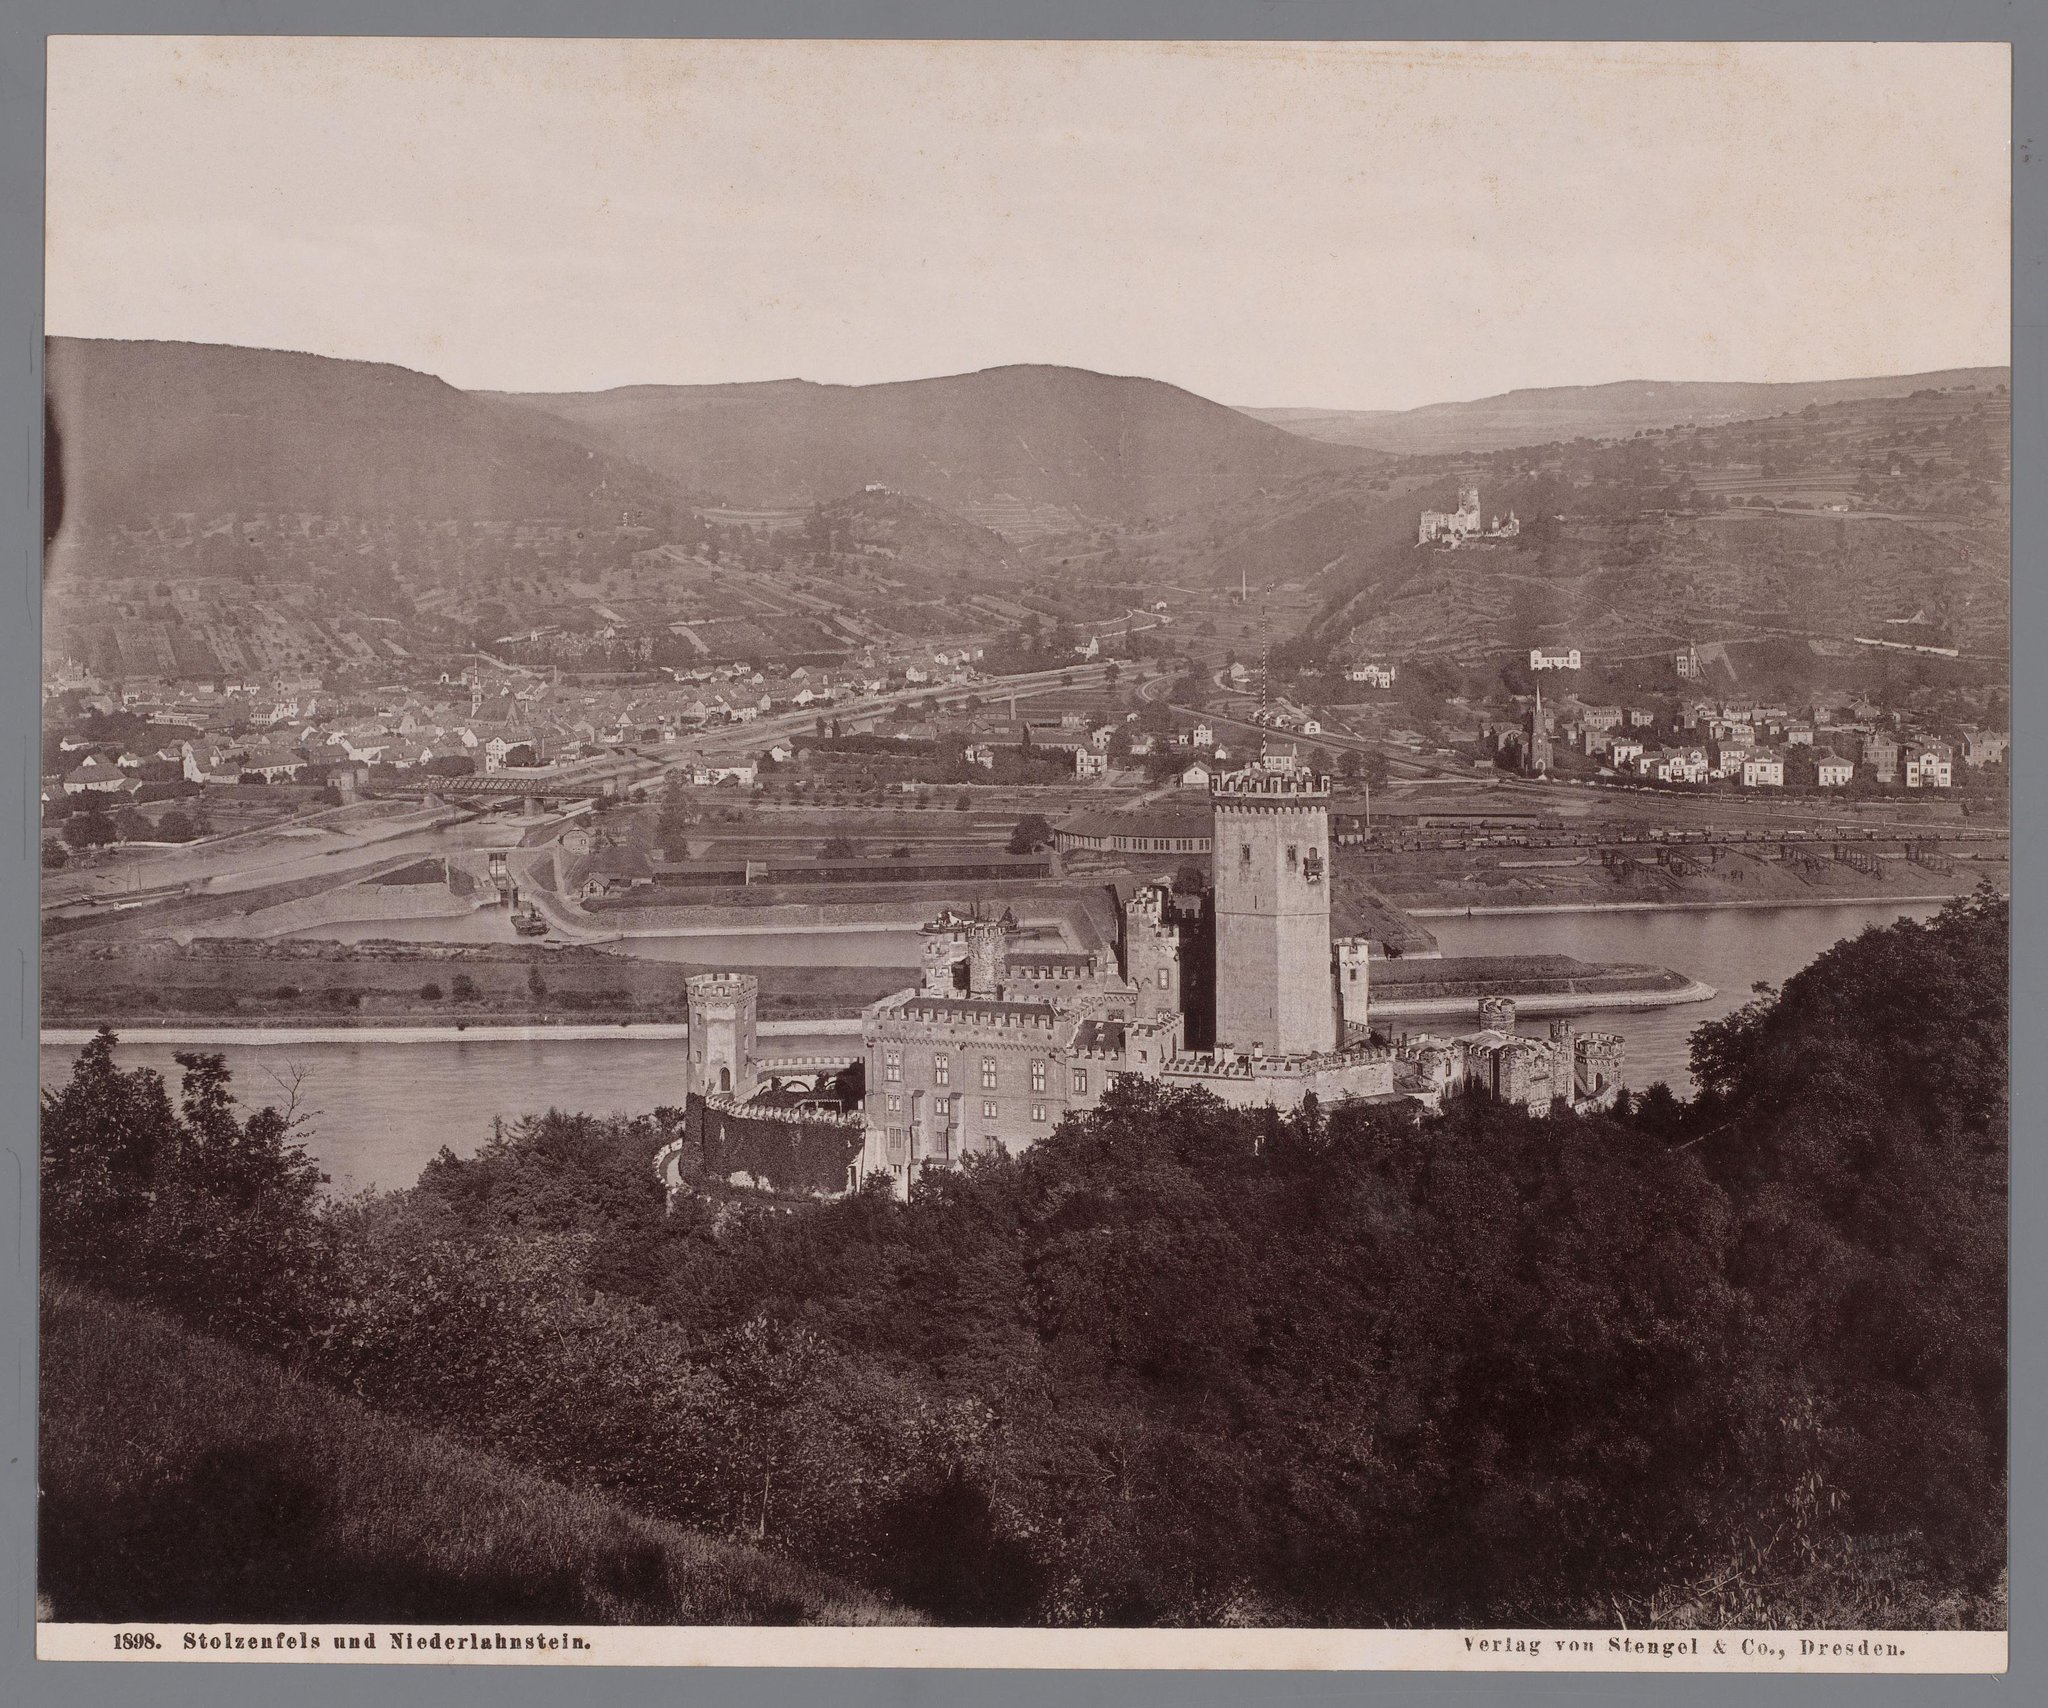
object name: photograph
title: Slot Stolzenfels und Niederlahnstein, bij Koblenz, Rheinland-Pfalz, Duitsland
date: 1890-1920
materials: paper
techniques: photoaquatint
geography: germany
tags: rijnland-palts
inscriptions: inscription: ‘1898. Stolzenfels und Niederlahnstein.’, inscription: ‘Verlag von Stengel & Co., Dresden.’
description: Het slot Stolzenfels staat boven de stad Koblenz aan de Rijn bij de monding van de Lahn op een heuvel. Niederlahnstein is een staddeel van Lahnstein.